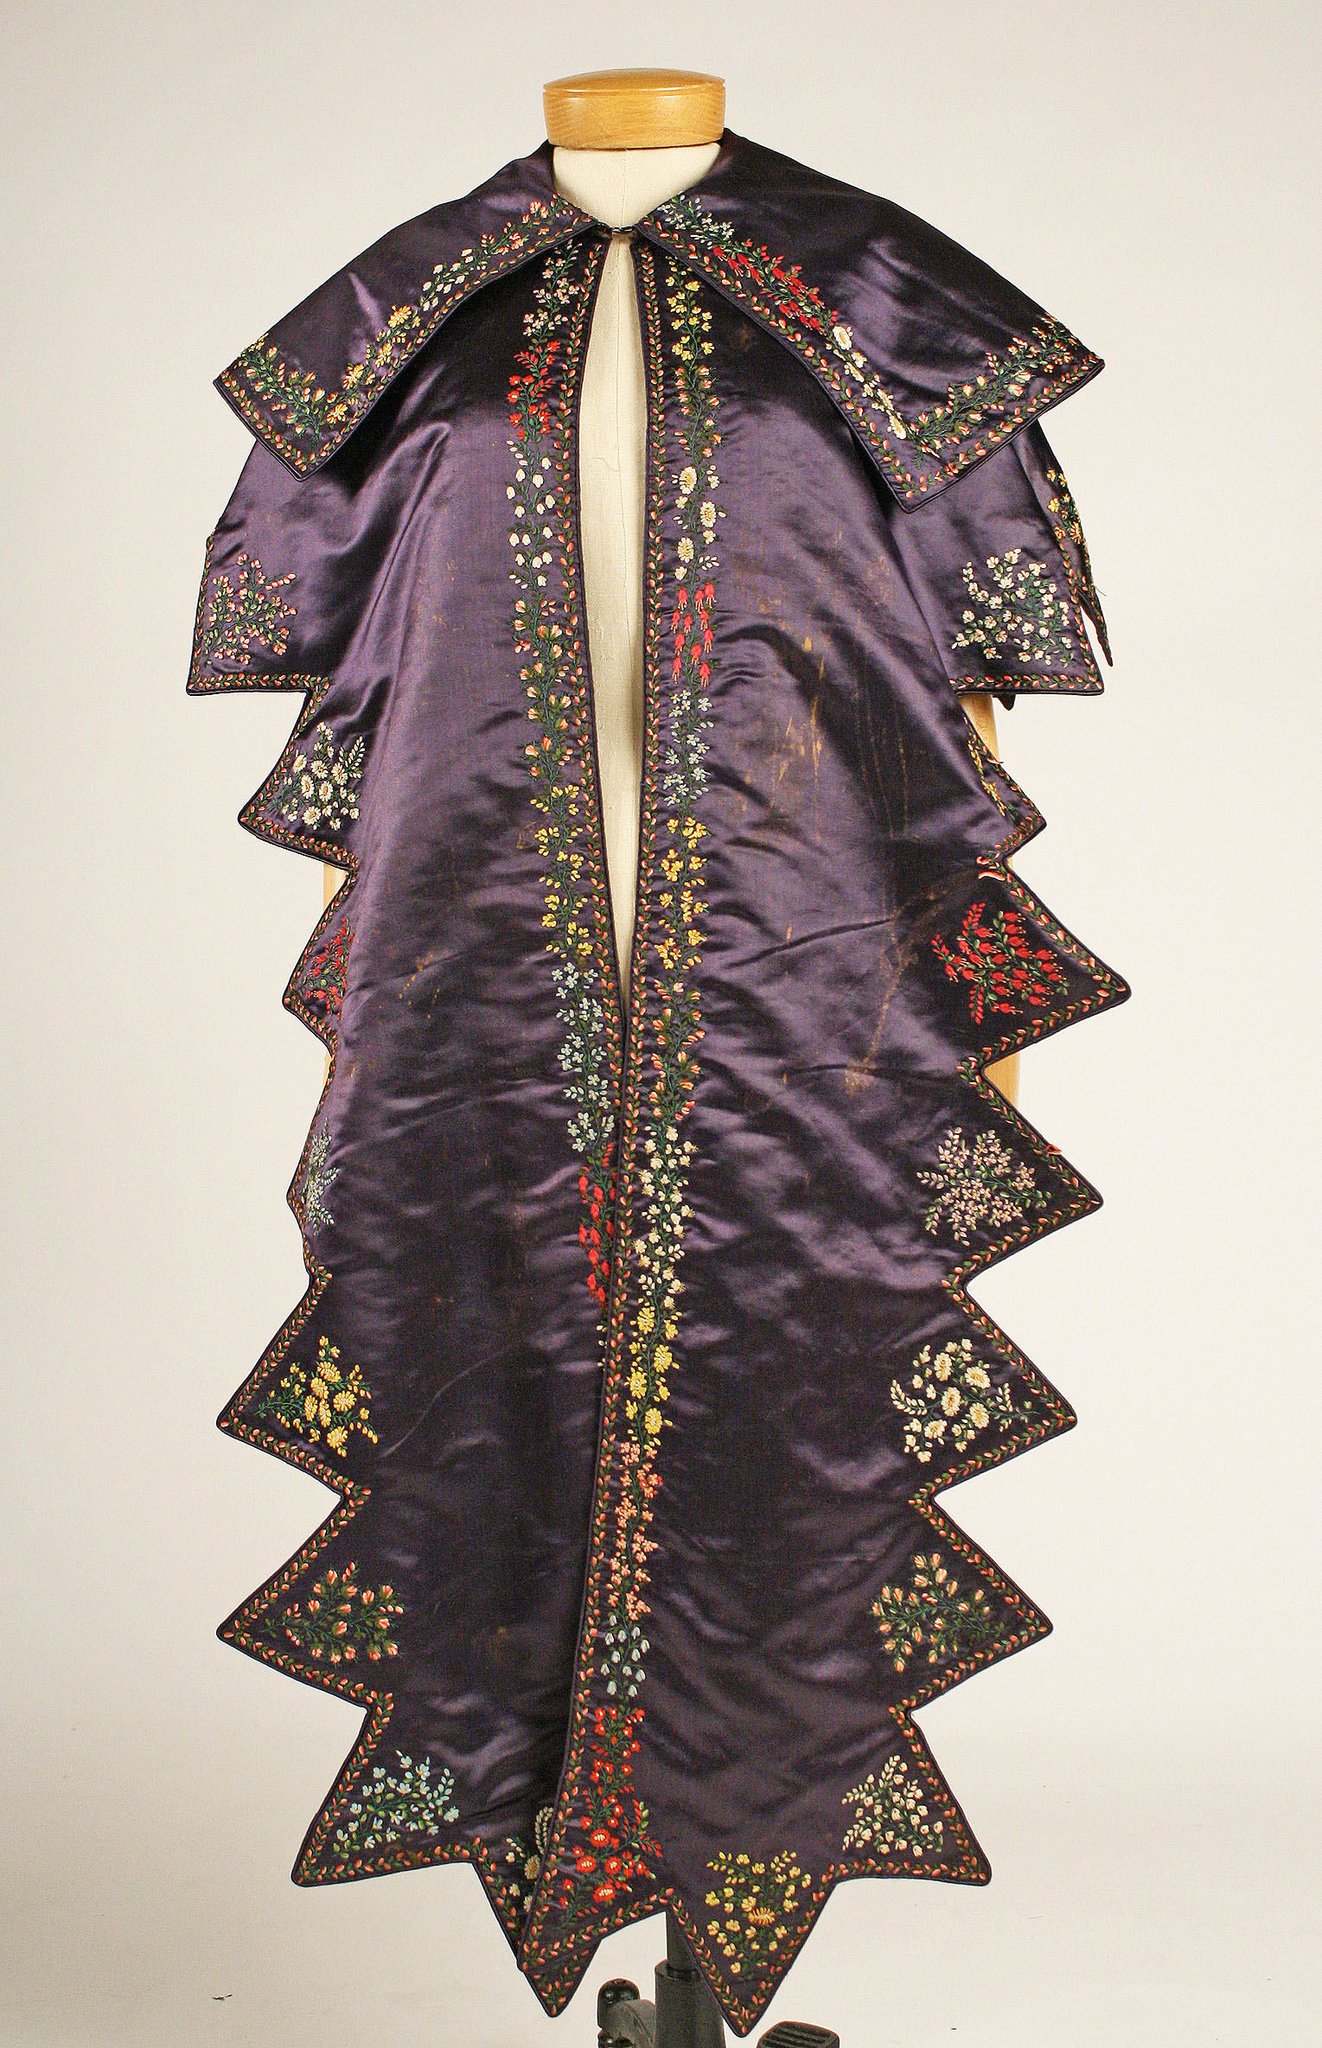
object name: pelerine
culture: british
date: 1830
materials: silk